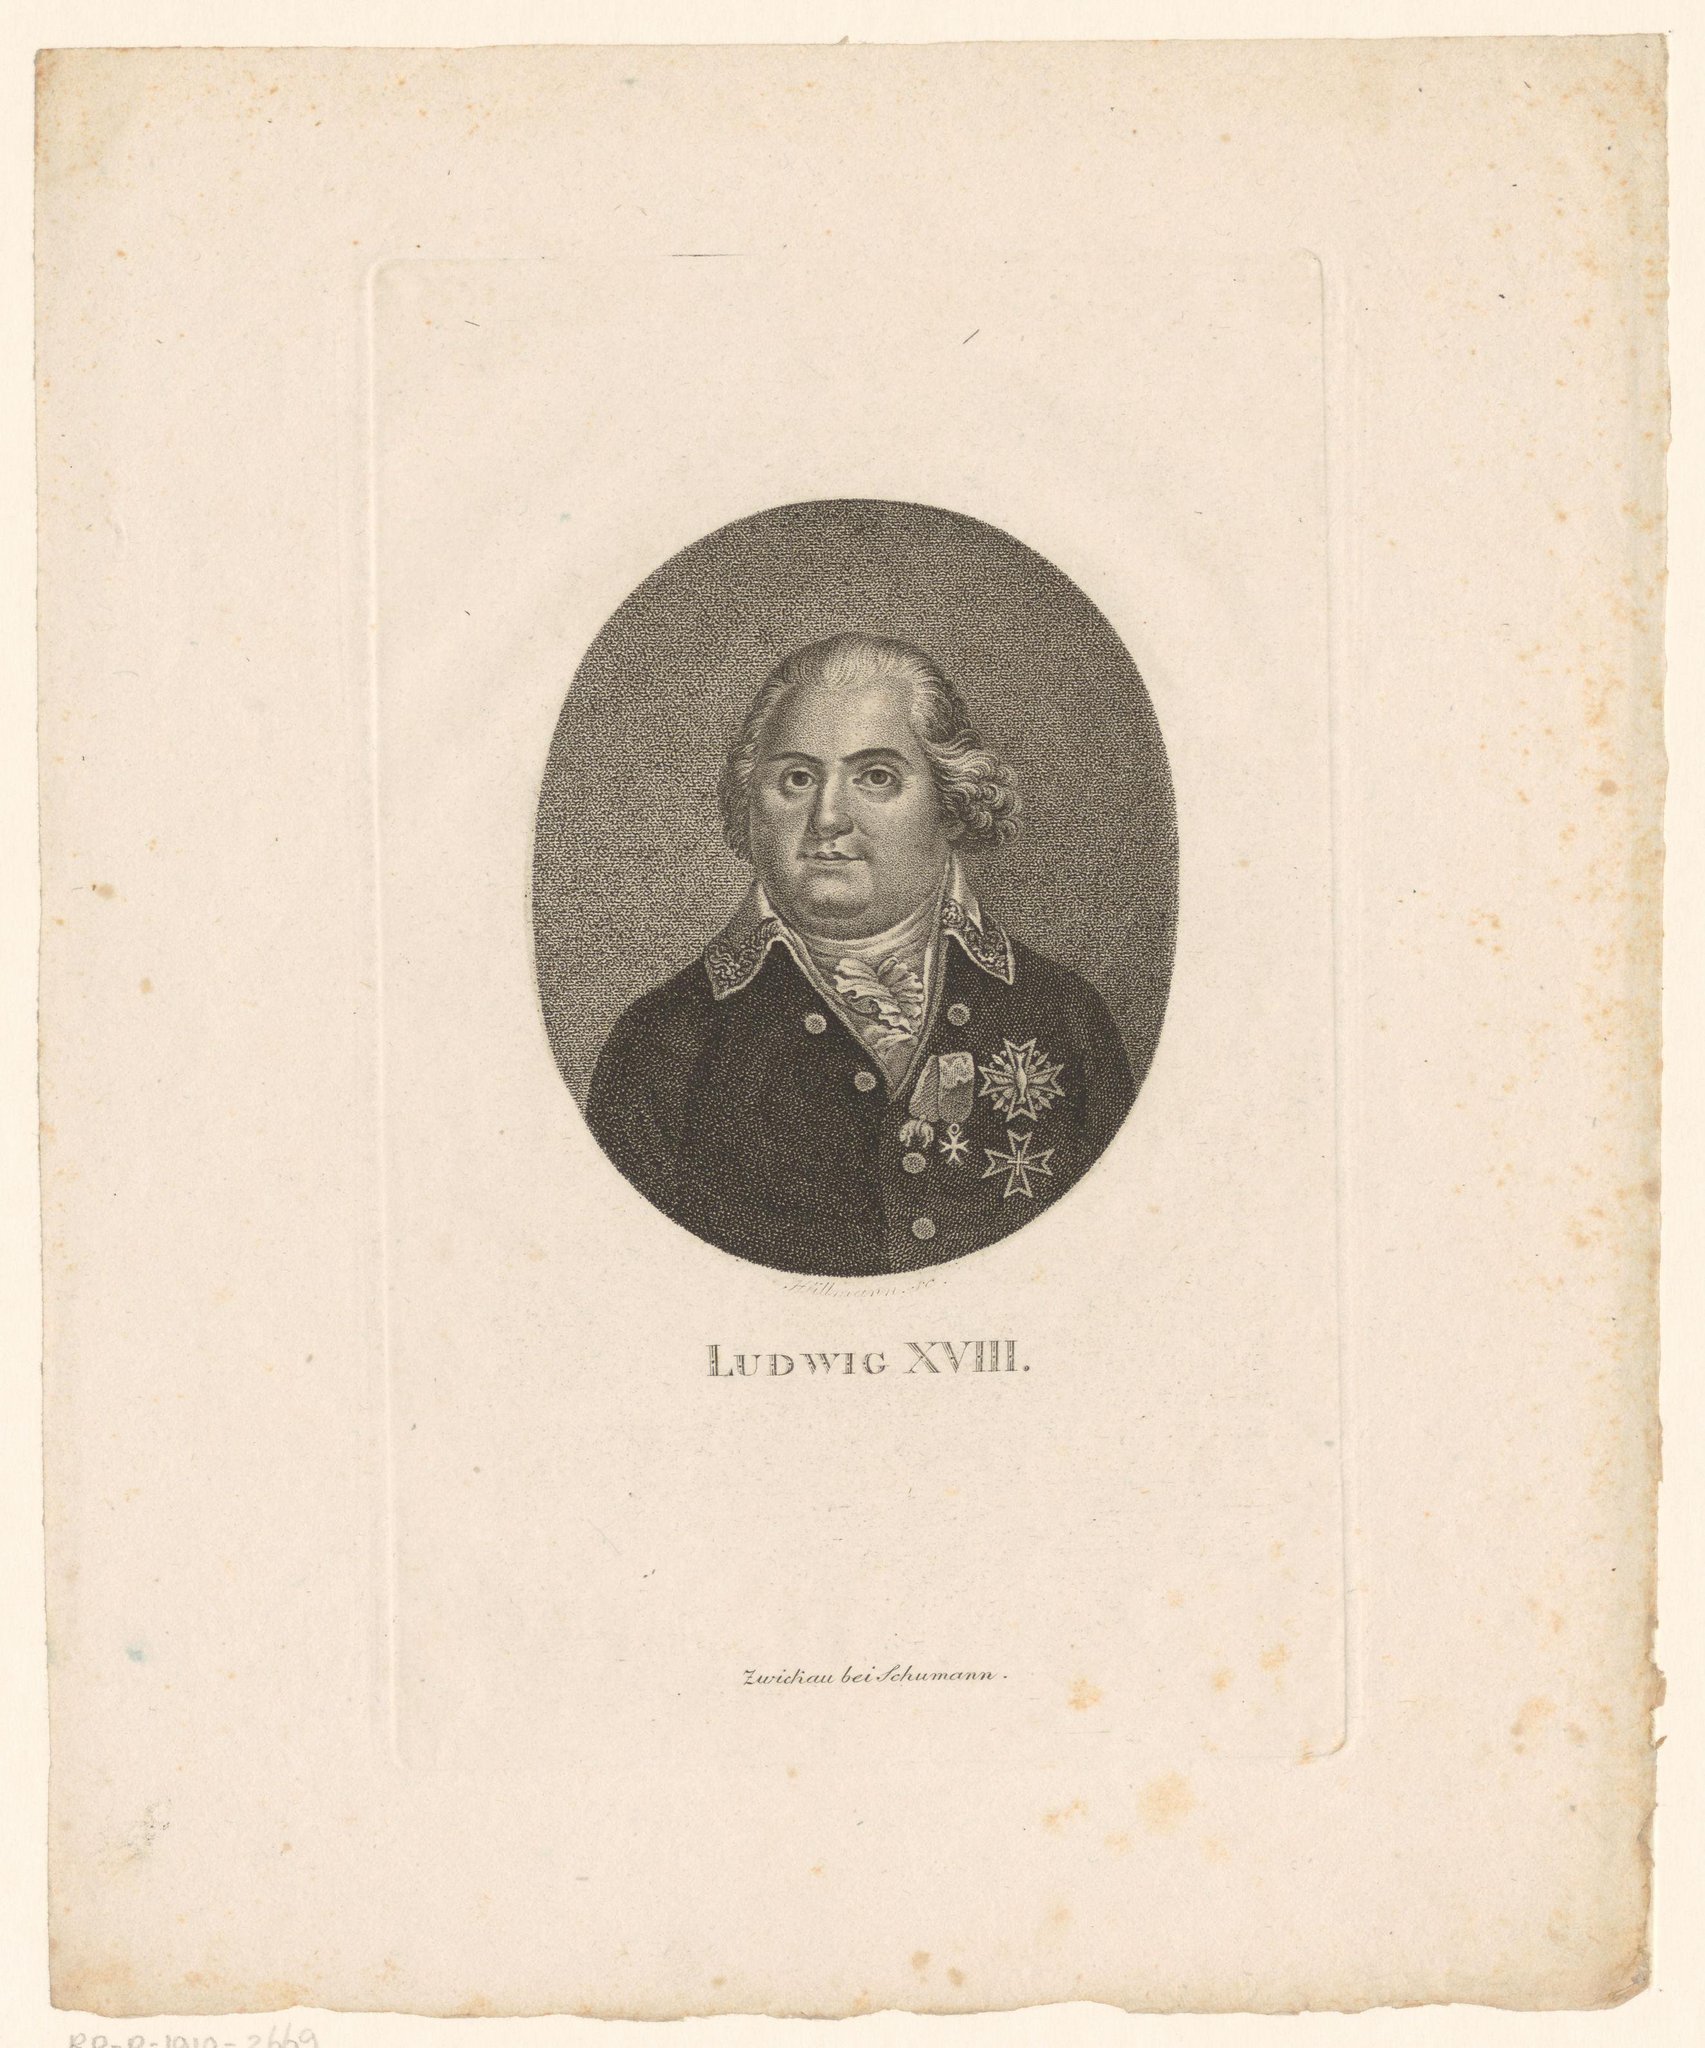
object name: print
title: Portret van Lodewijk XVIII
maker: gottlieb wilhelm hüllmann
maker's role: print maker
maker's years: 1765-1828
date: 1775-1828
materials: paper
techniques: stippling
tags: paris, lodewijk xviii (koning van frankrijk), historical persons, medals and other marks of military honour, knighthood order of the holy spirit, knighthood order of the golden fleece - insignia of a knighthood order, e.g.: badge, chain (with name of order), king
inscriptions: collector's mark: Lugt 2228